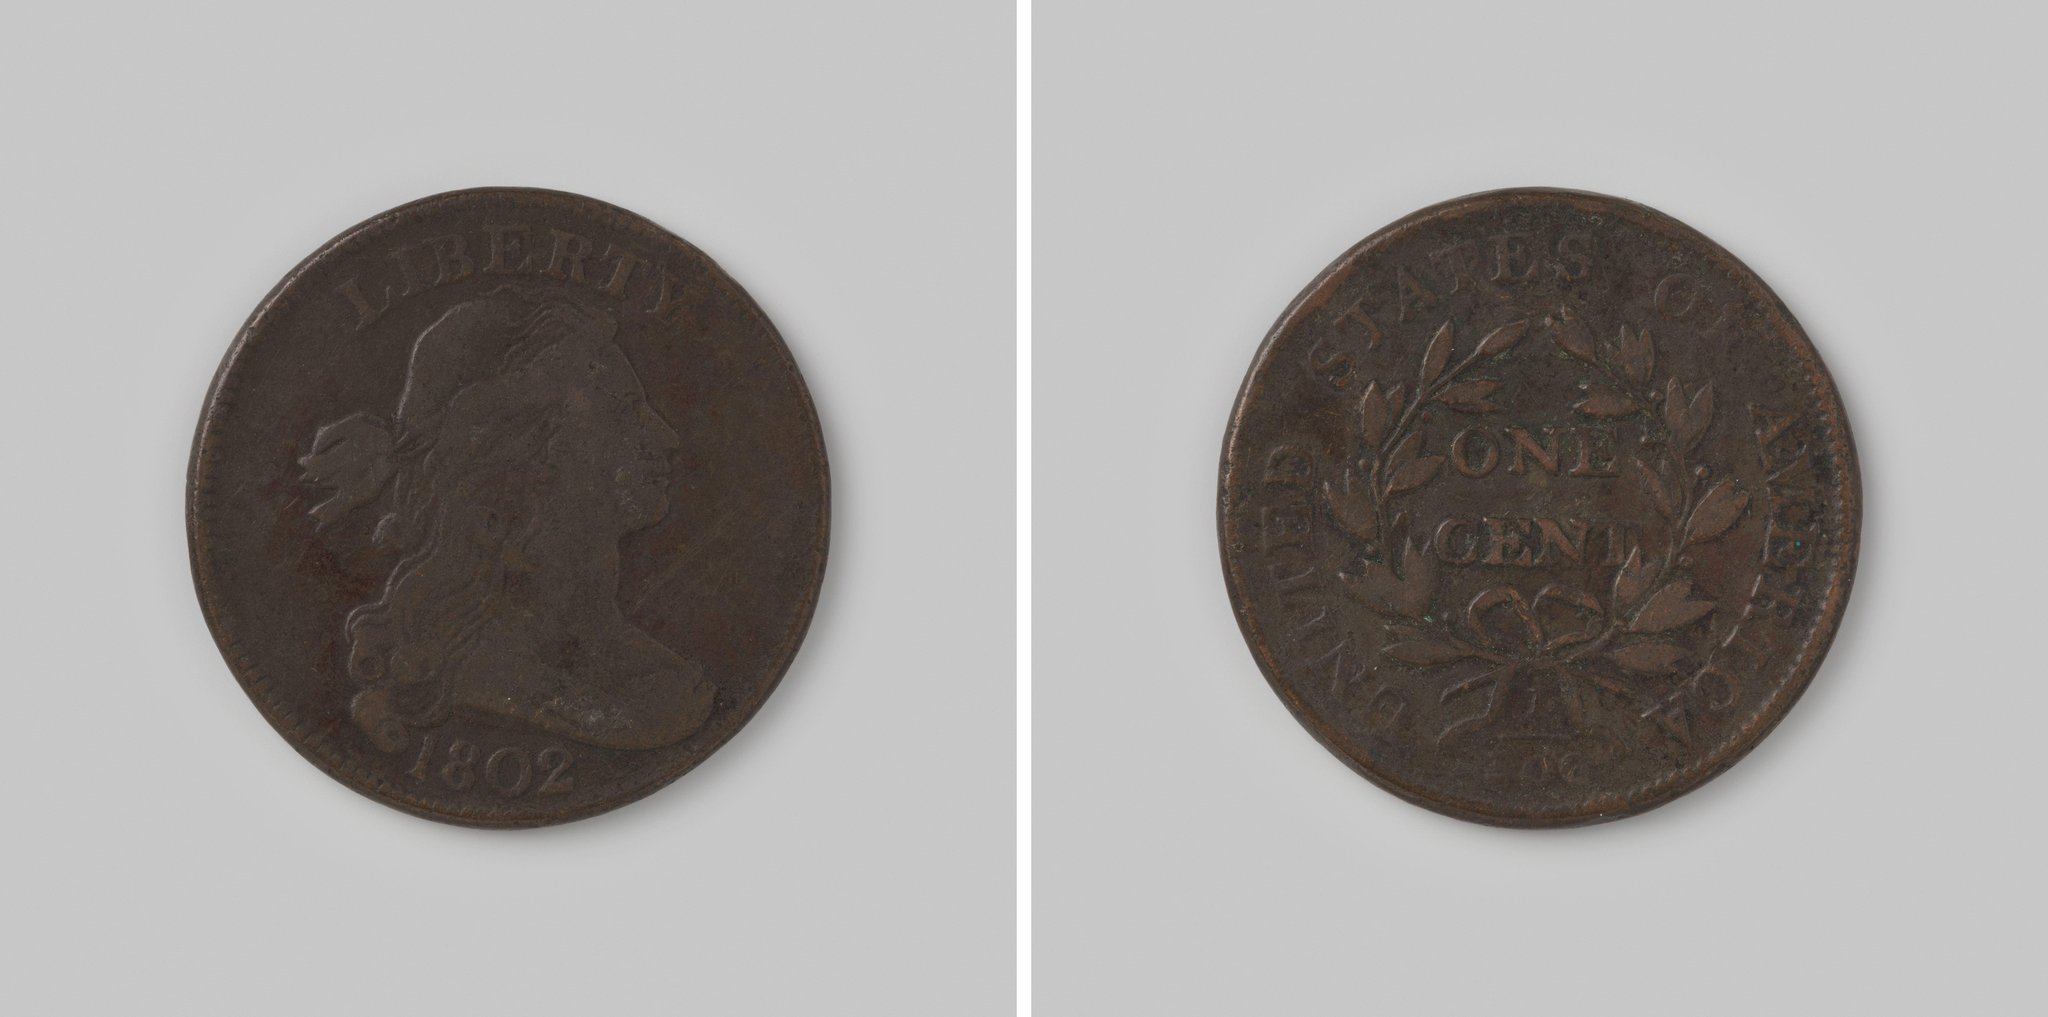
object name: coin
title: Verenigde Staten van Amerika, cent, 1802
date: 1802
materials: copper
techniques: striking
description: Koperen munt. Voorzijde: liberty (draped bust) naar rechts. Onderaan jaartal. Keerzijde: tussen twee met grote strik samengebonden takken waarde-aanduiding: one cent in twee regels. Onderaan tussen linten waarde-aanduiding: 1/100. Gladde rand.